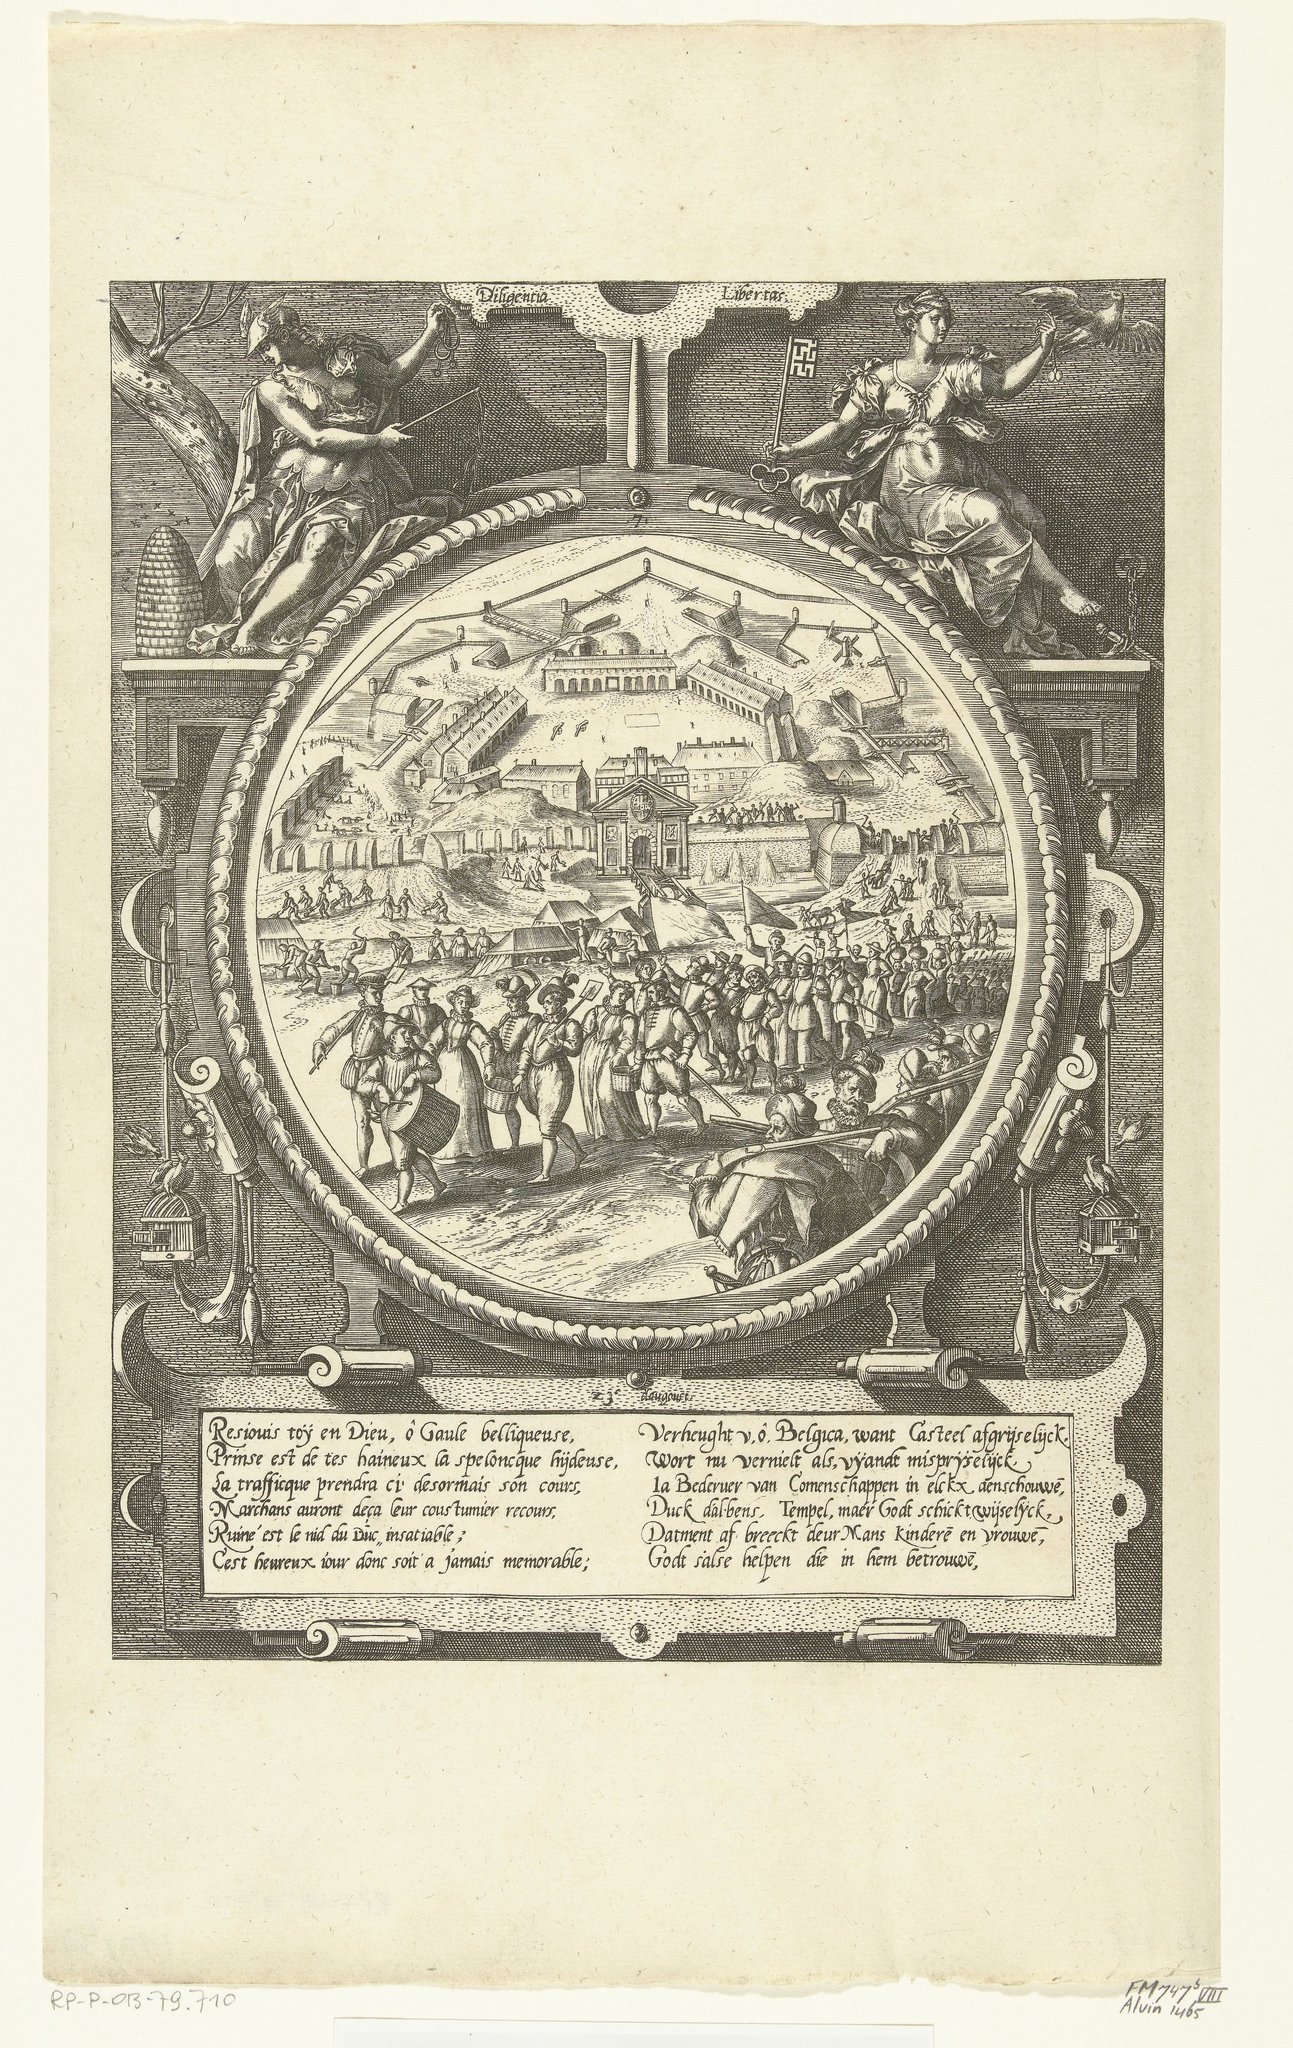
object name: print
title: Reproductie van de prent met het afgraven van de bolwerken door de Antwerpenaren, 1577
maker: william stirling maxwell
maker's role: politician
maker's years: 1818-1878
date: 1877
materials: paper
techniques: photolithography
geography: great britain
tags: industriousness, assiduity; 'assiduità', 'industria', 'zelo' (ripa), demolition of building, freedom, liberty; 'libertà' (ripa), carefulness, diligence; 'diligenza' (ripa)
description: Reproductie van de prent met het afgraven van de bolwerken door de Antwerpenaren, 23 augustus 1577. Optocht van inwoners van Antwerpen gewapend met spades en manden op weg naar de citadel. Op de achtergrond het slopen en afgraven van de vesting. Voorstelling in een rond medaillon met ornamentele allegorische omlijsting met bovenaan de zittende vrouwelijke personificaties van Vlijt (Diligentia) en Vrijheid (Libertas). Onderaan een cartouche met 2 verzen van elk 6 regels in het Frans en Nederlands.